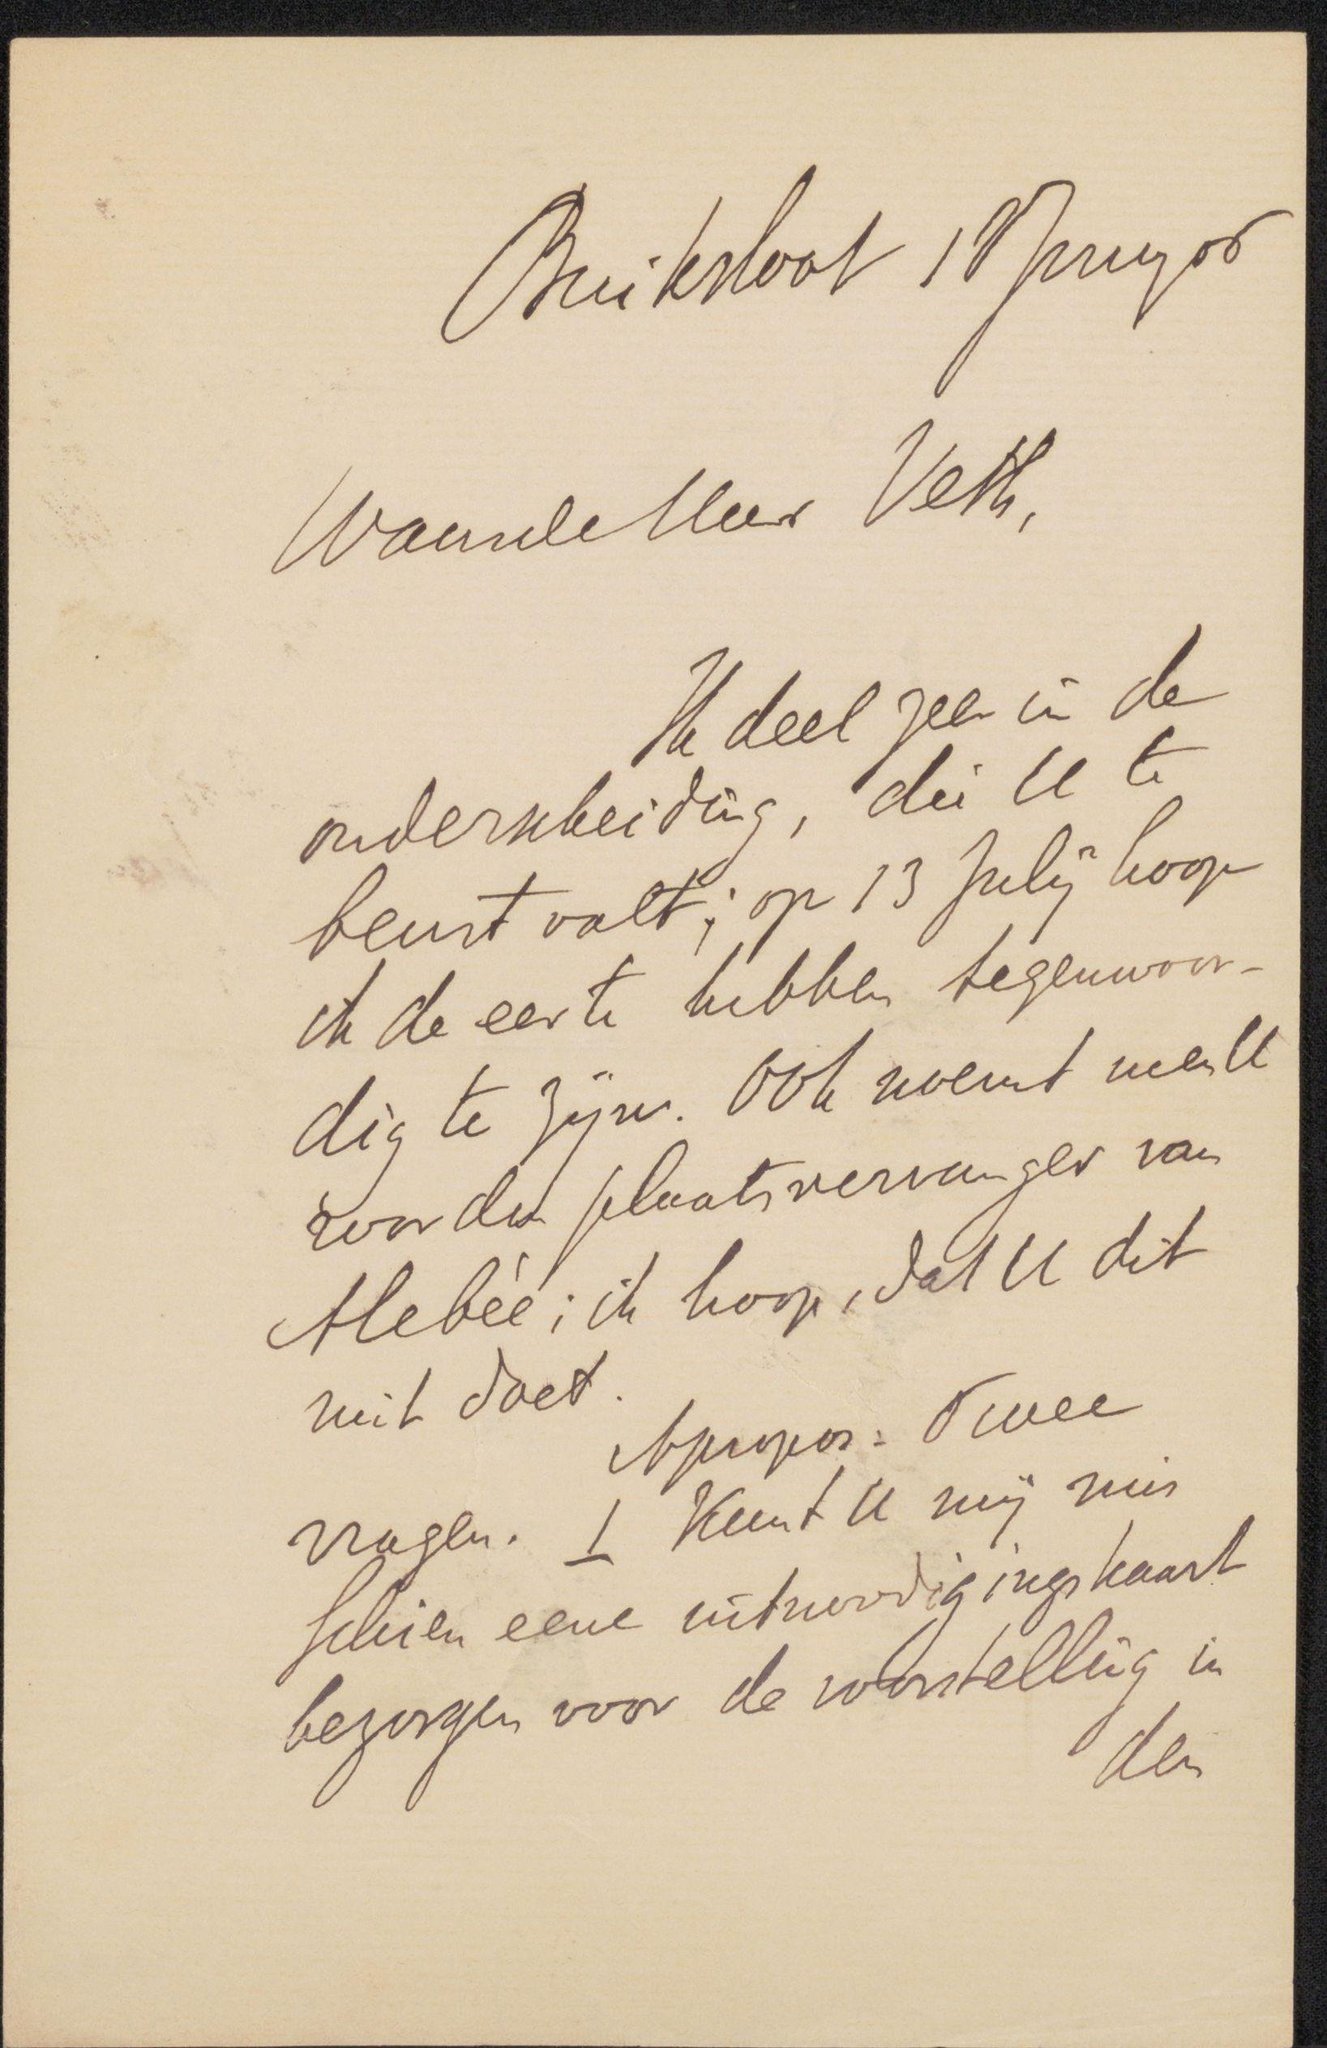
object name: letter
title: Brief aan Jan Veth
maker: jonkheer jacob hendrik schorer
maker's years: 1839-1931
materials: ink, paper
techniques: pen, writing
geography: buiksloot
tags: august allebé, dordrecht, amsterdam, painter, draughtsman, designer, jan veth, the arts of the stage: ballet, theatre, musical drama, motion picture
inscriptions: collector's mark: ‘RPK’, watermark